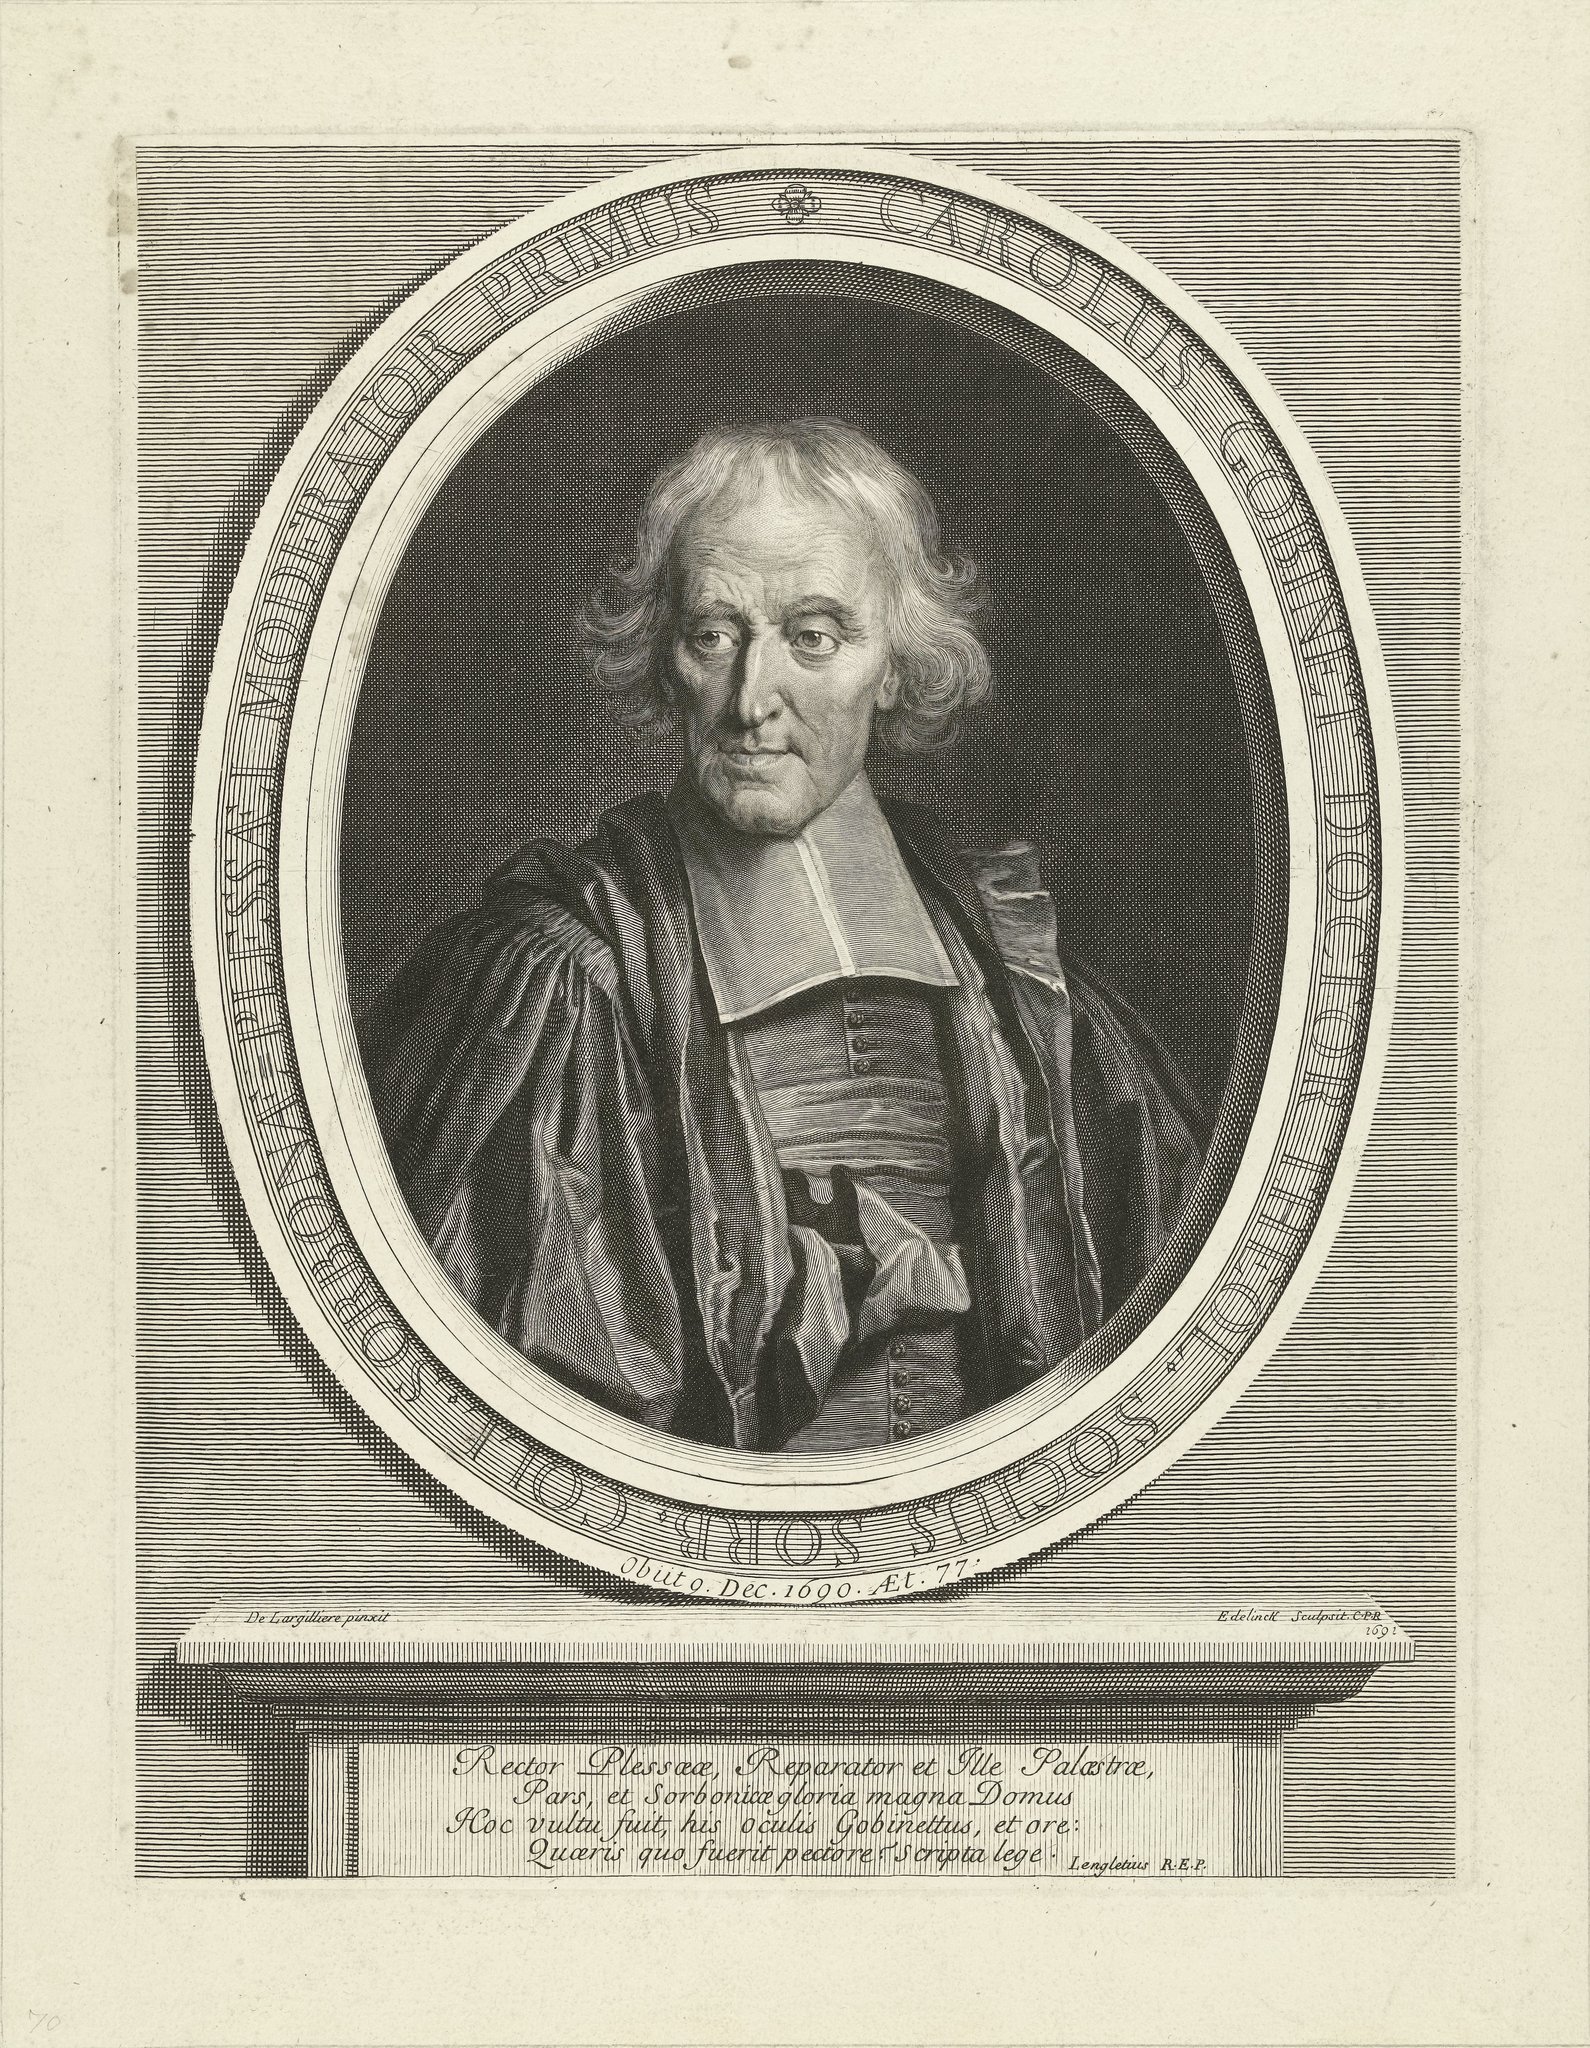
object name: print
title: Portret van Charles Gobinet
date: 1691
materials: paper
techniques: engraving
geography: france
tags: paris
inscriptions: collector's mark: Lugt 240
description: Portret van Charles Gobinet (1612-1690) afgebeeld in ovale omlijsting met tekst, waaronder console met Latijnse tekst bestaande uit vier regels.